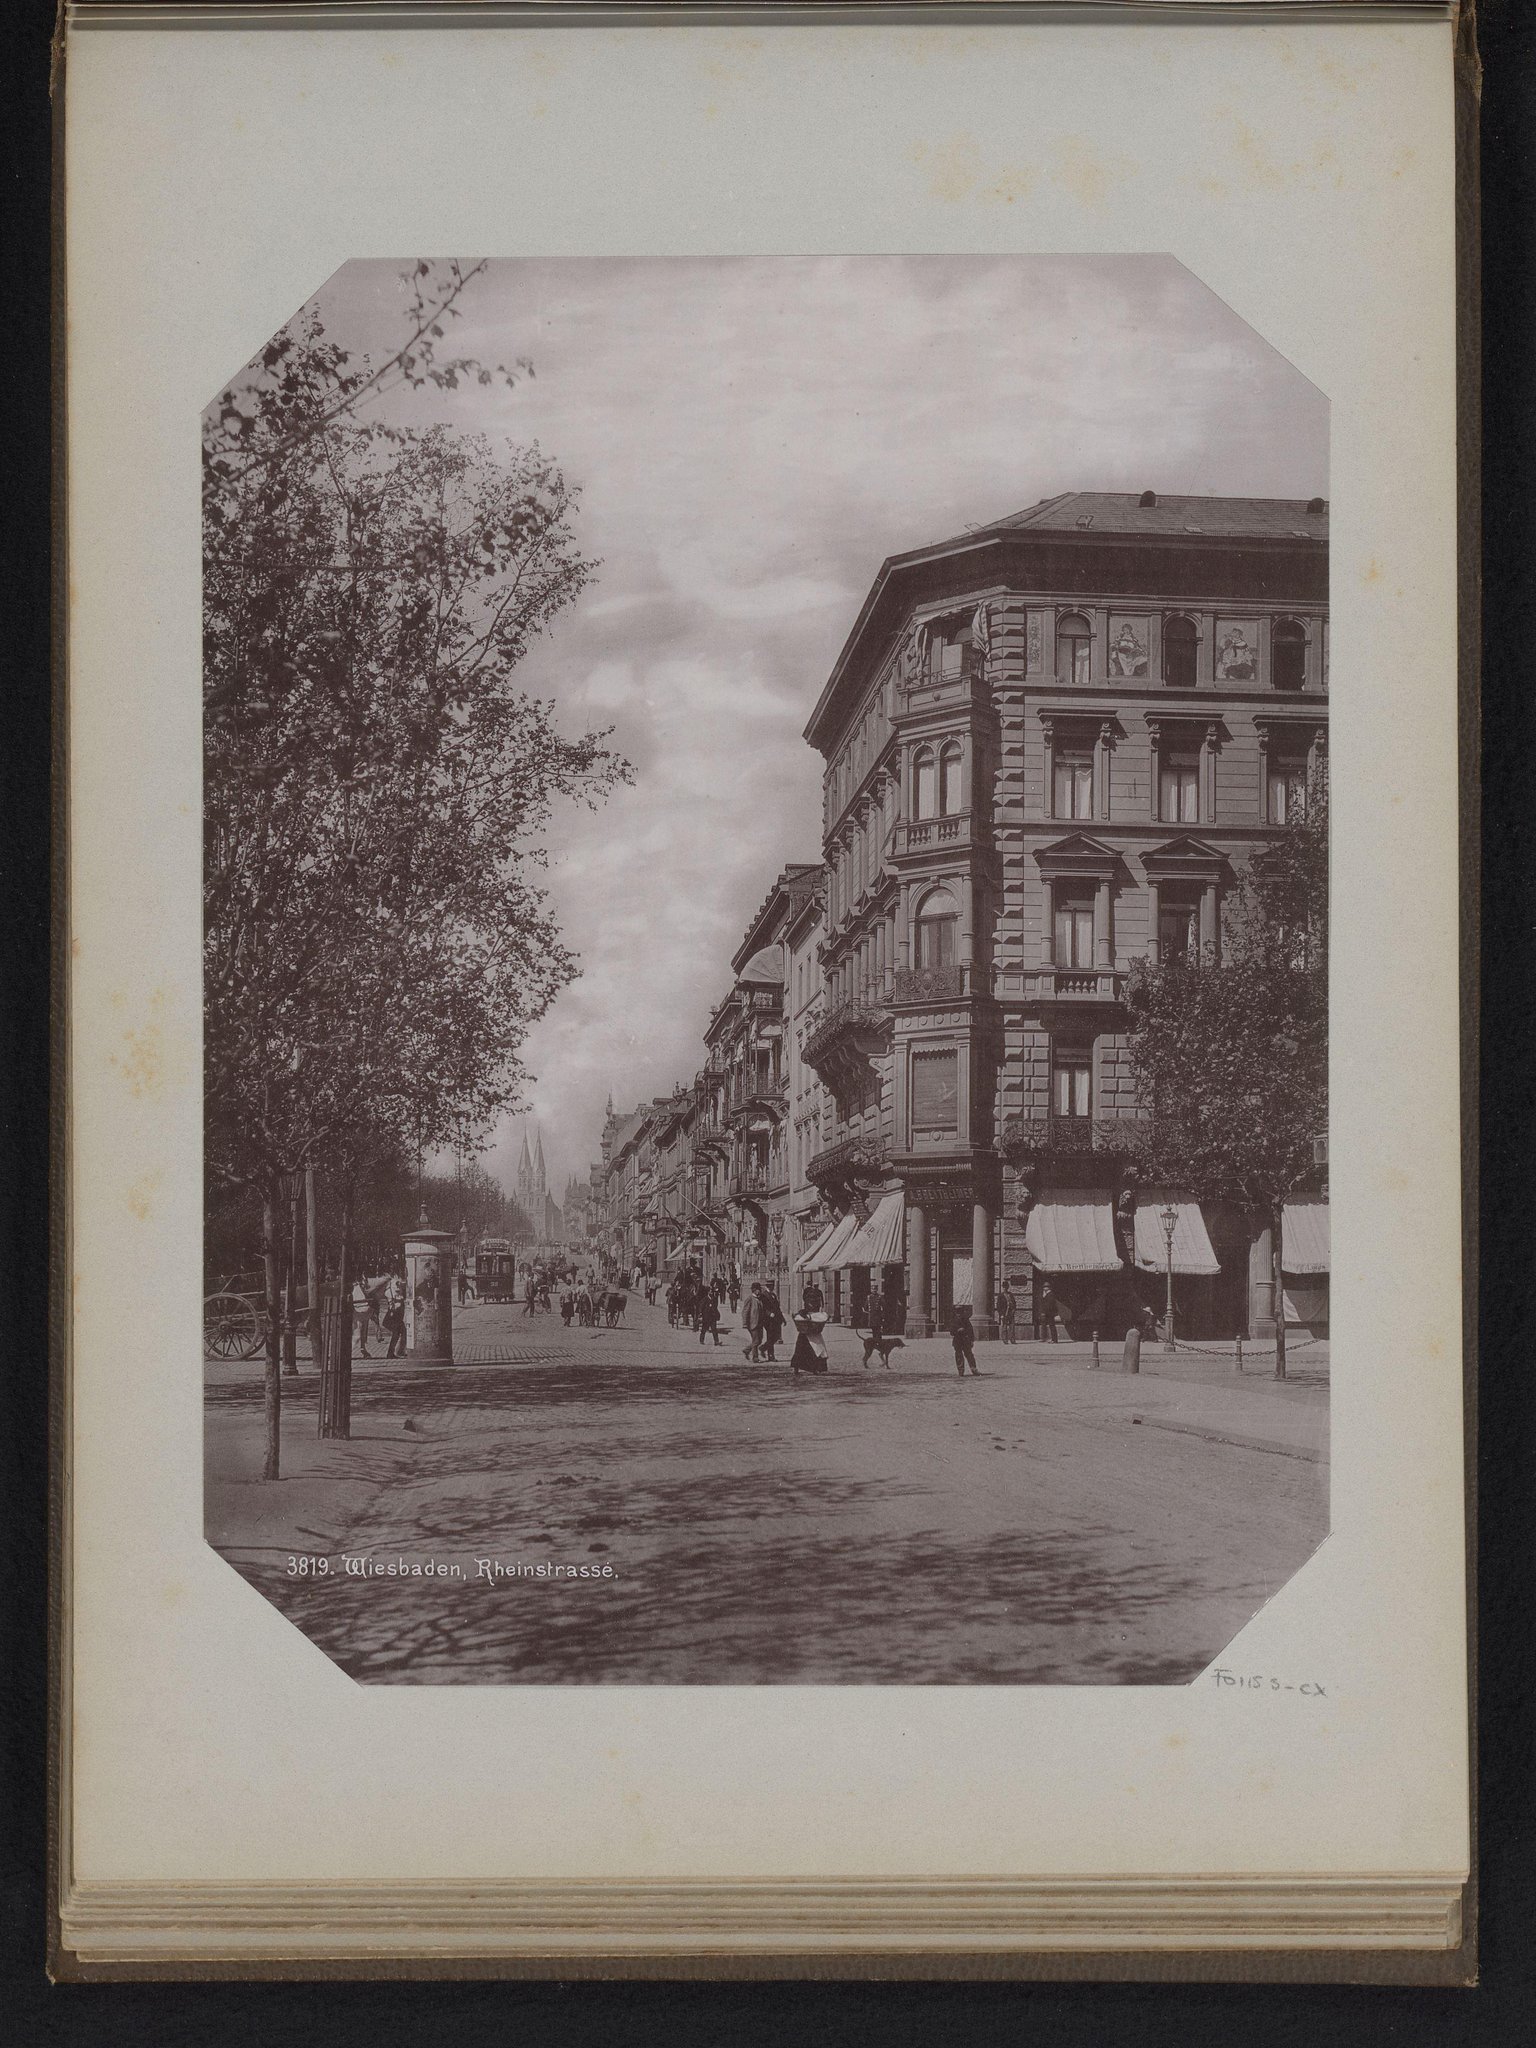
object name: photomechanical print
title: Gezicht op de Rheinstrasse te Wiesbaden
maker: Anonymous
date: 1890-1899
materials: paper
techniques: photograph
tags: street (+ city(-scape) with figures, staffage)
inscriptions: inscription: ‘3819. Wiesbaden, Rheinstrasse’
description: Deze prent maakt deel uit van een album.